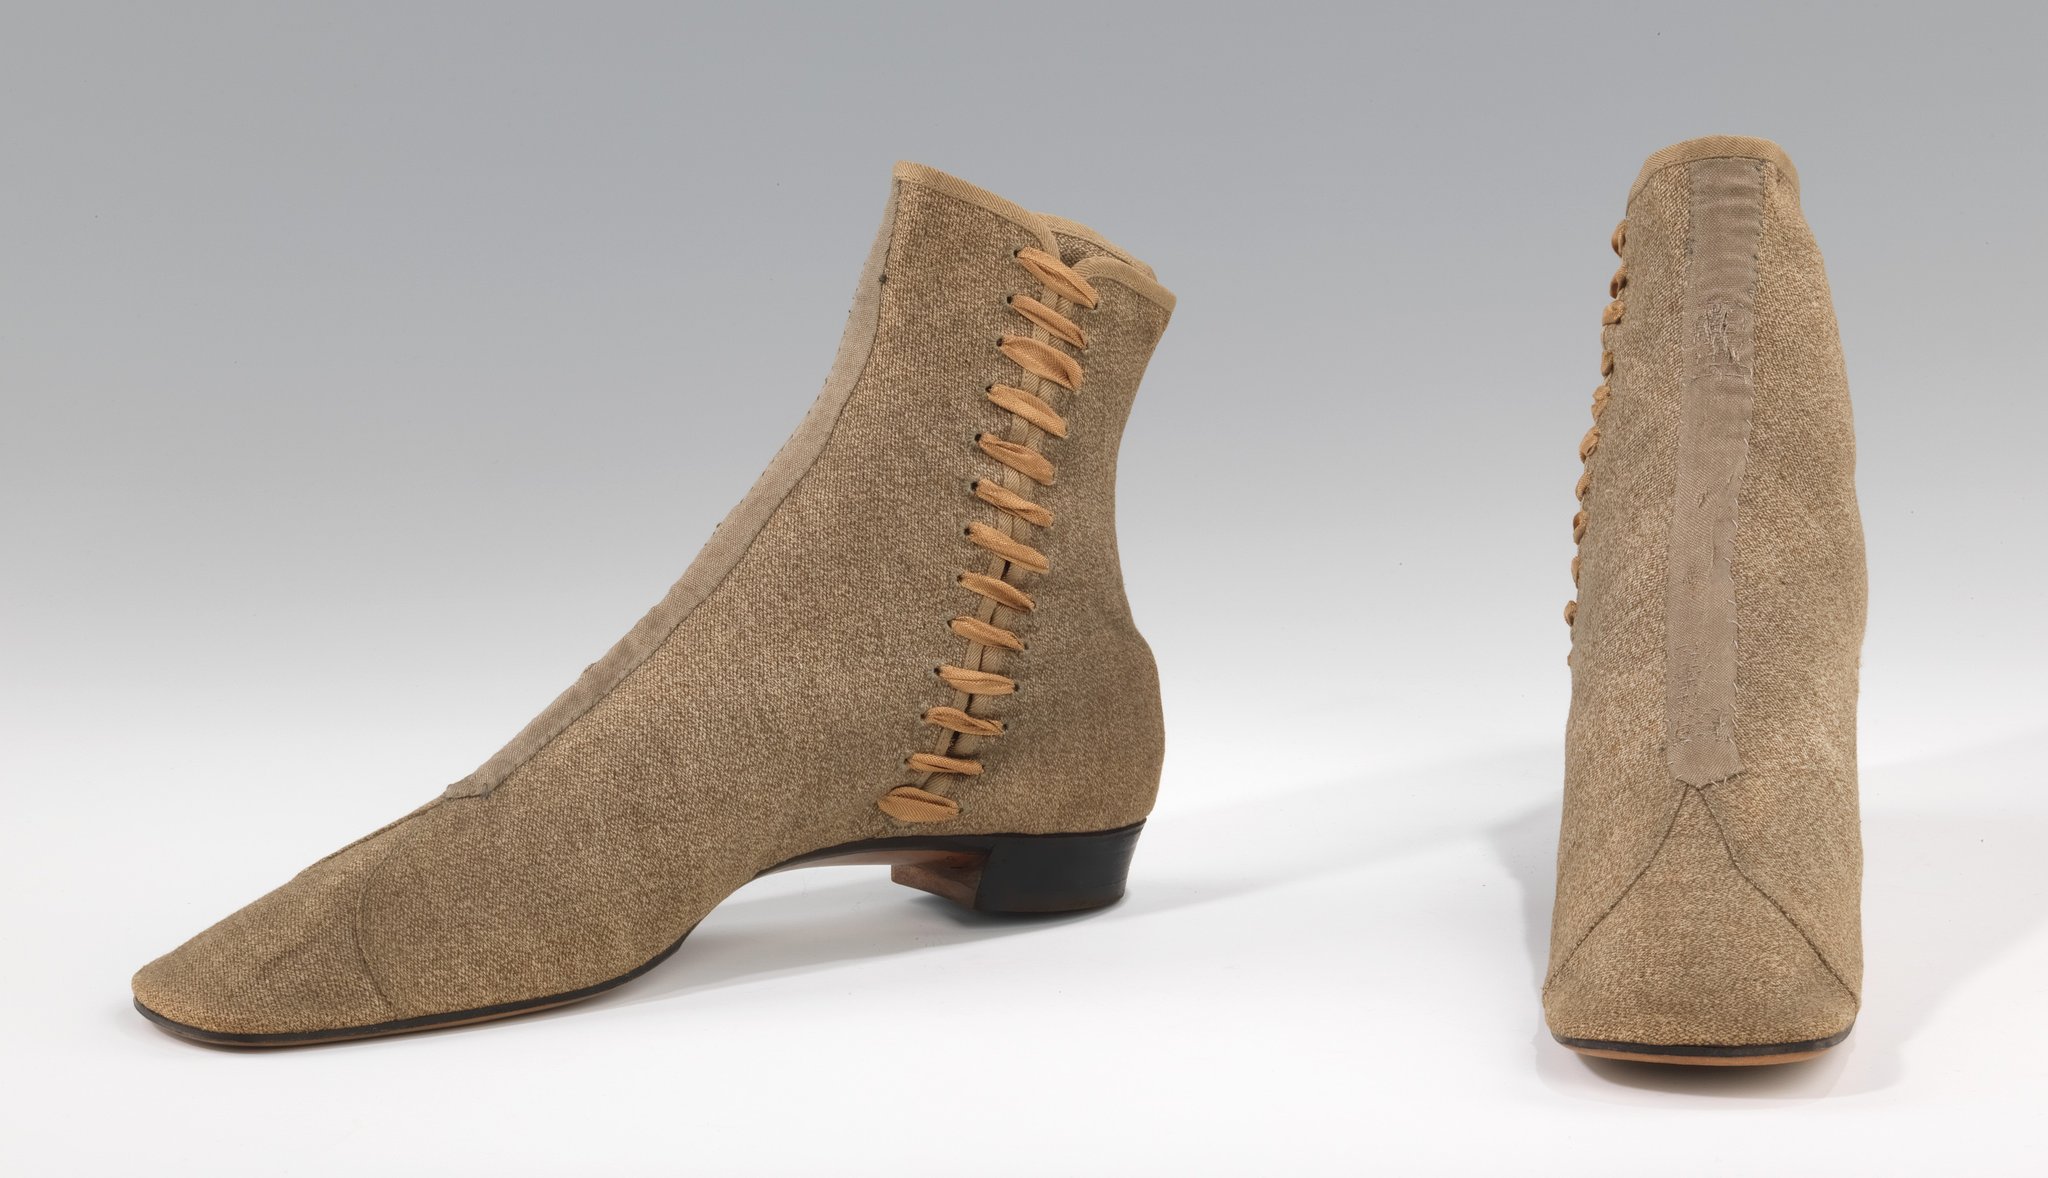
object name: boot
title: Boots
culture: american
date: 1865-1875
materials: cotton, silk